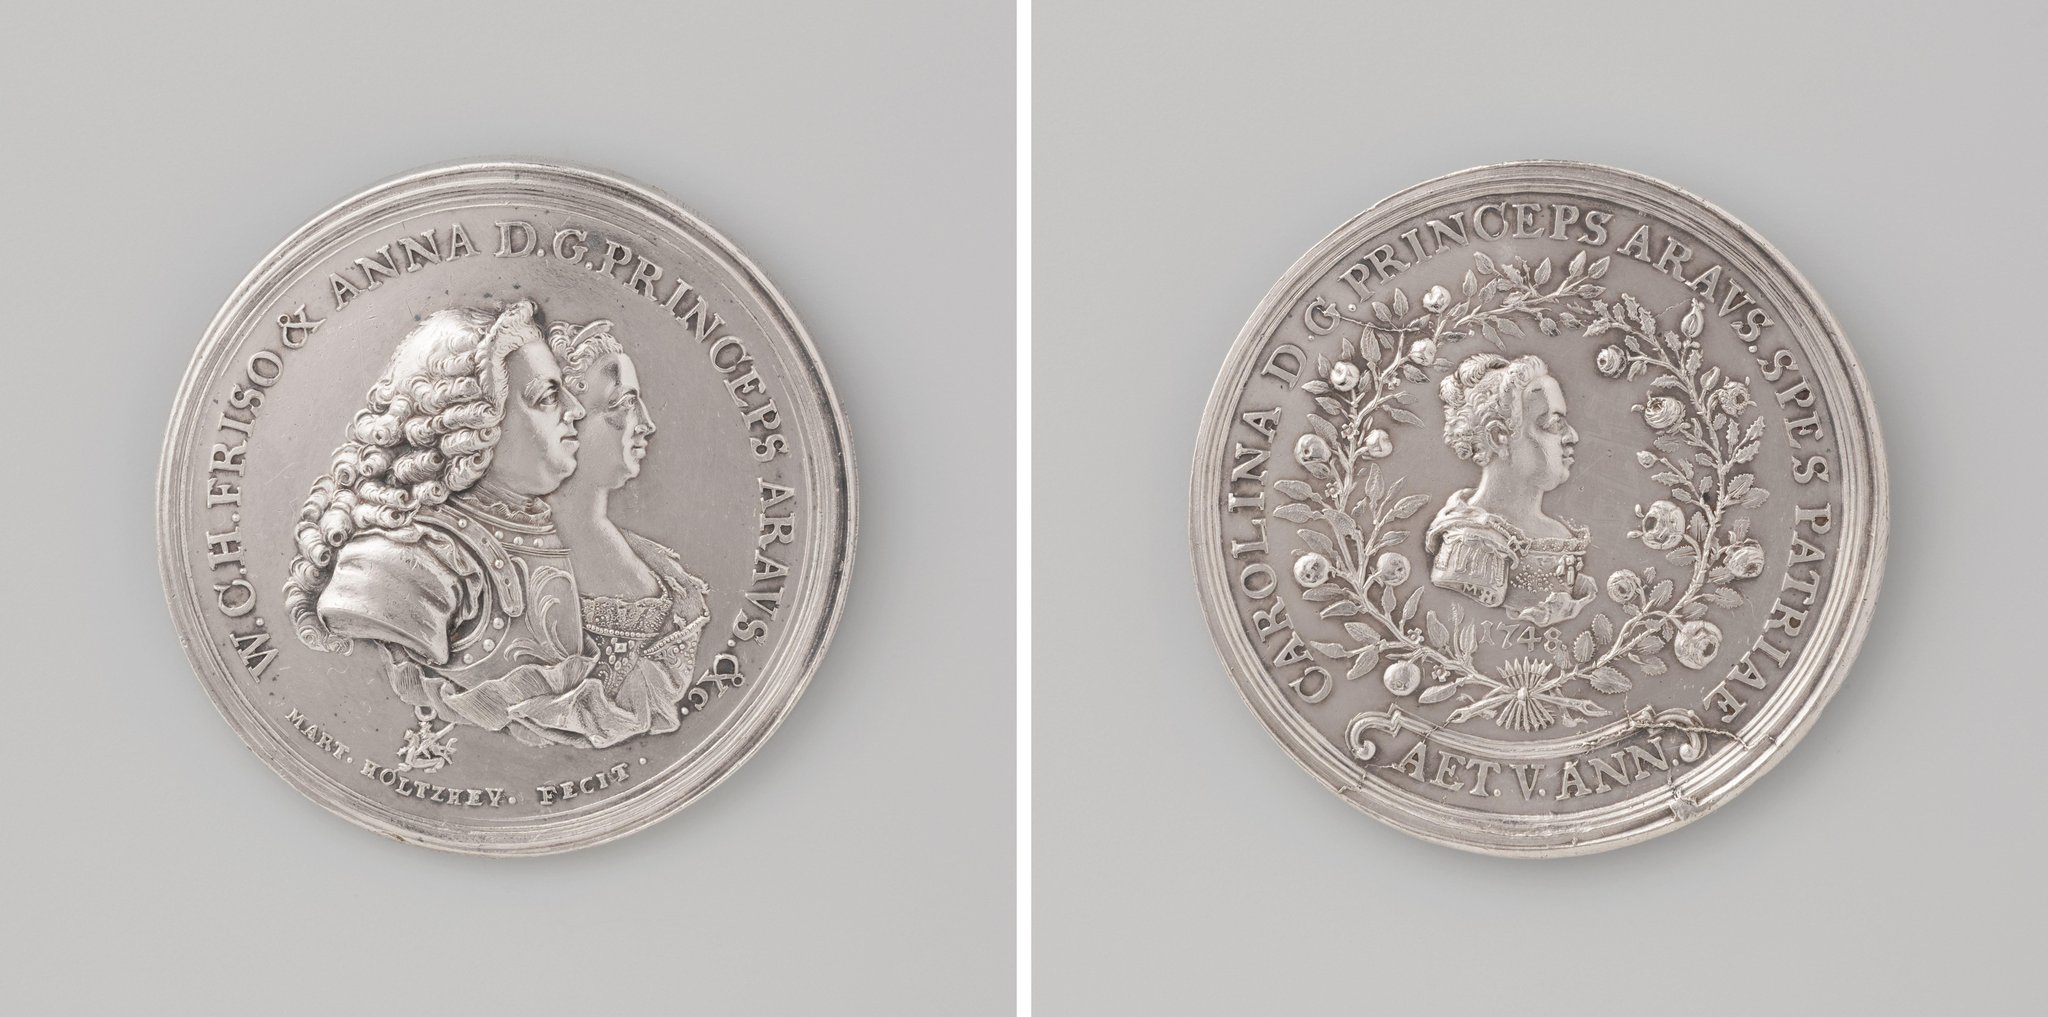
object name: history medal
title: Vijfde verjaardag van prinses Carolina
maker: martinus holtzhey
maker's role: medailleur, muntmaker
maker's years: 1697-1764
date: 1748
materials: silver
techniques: striking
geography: amsterdam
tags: carolina (prinses van oranje-nassau), willem iv (prins van oranje-nassau), the hague, anna van hannover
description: Zilveren penning. Voorzijde: borststuk man en vrouw met diadeem binnen omschrift. Keerzijde: borststuk jong meisje boven jaartal binnen krans van oranjetak en rozetak, met lint gebonden aan pijlenbundel boven opschrift in een lijst binnen omschrift